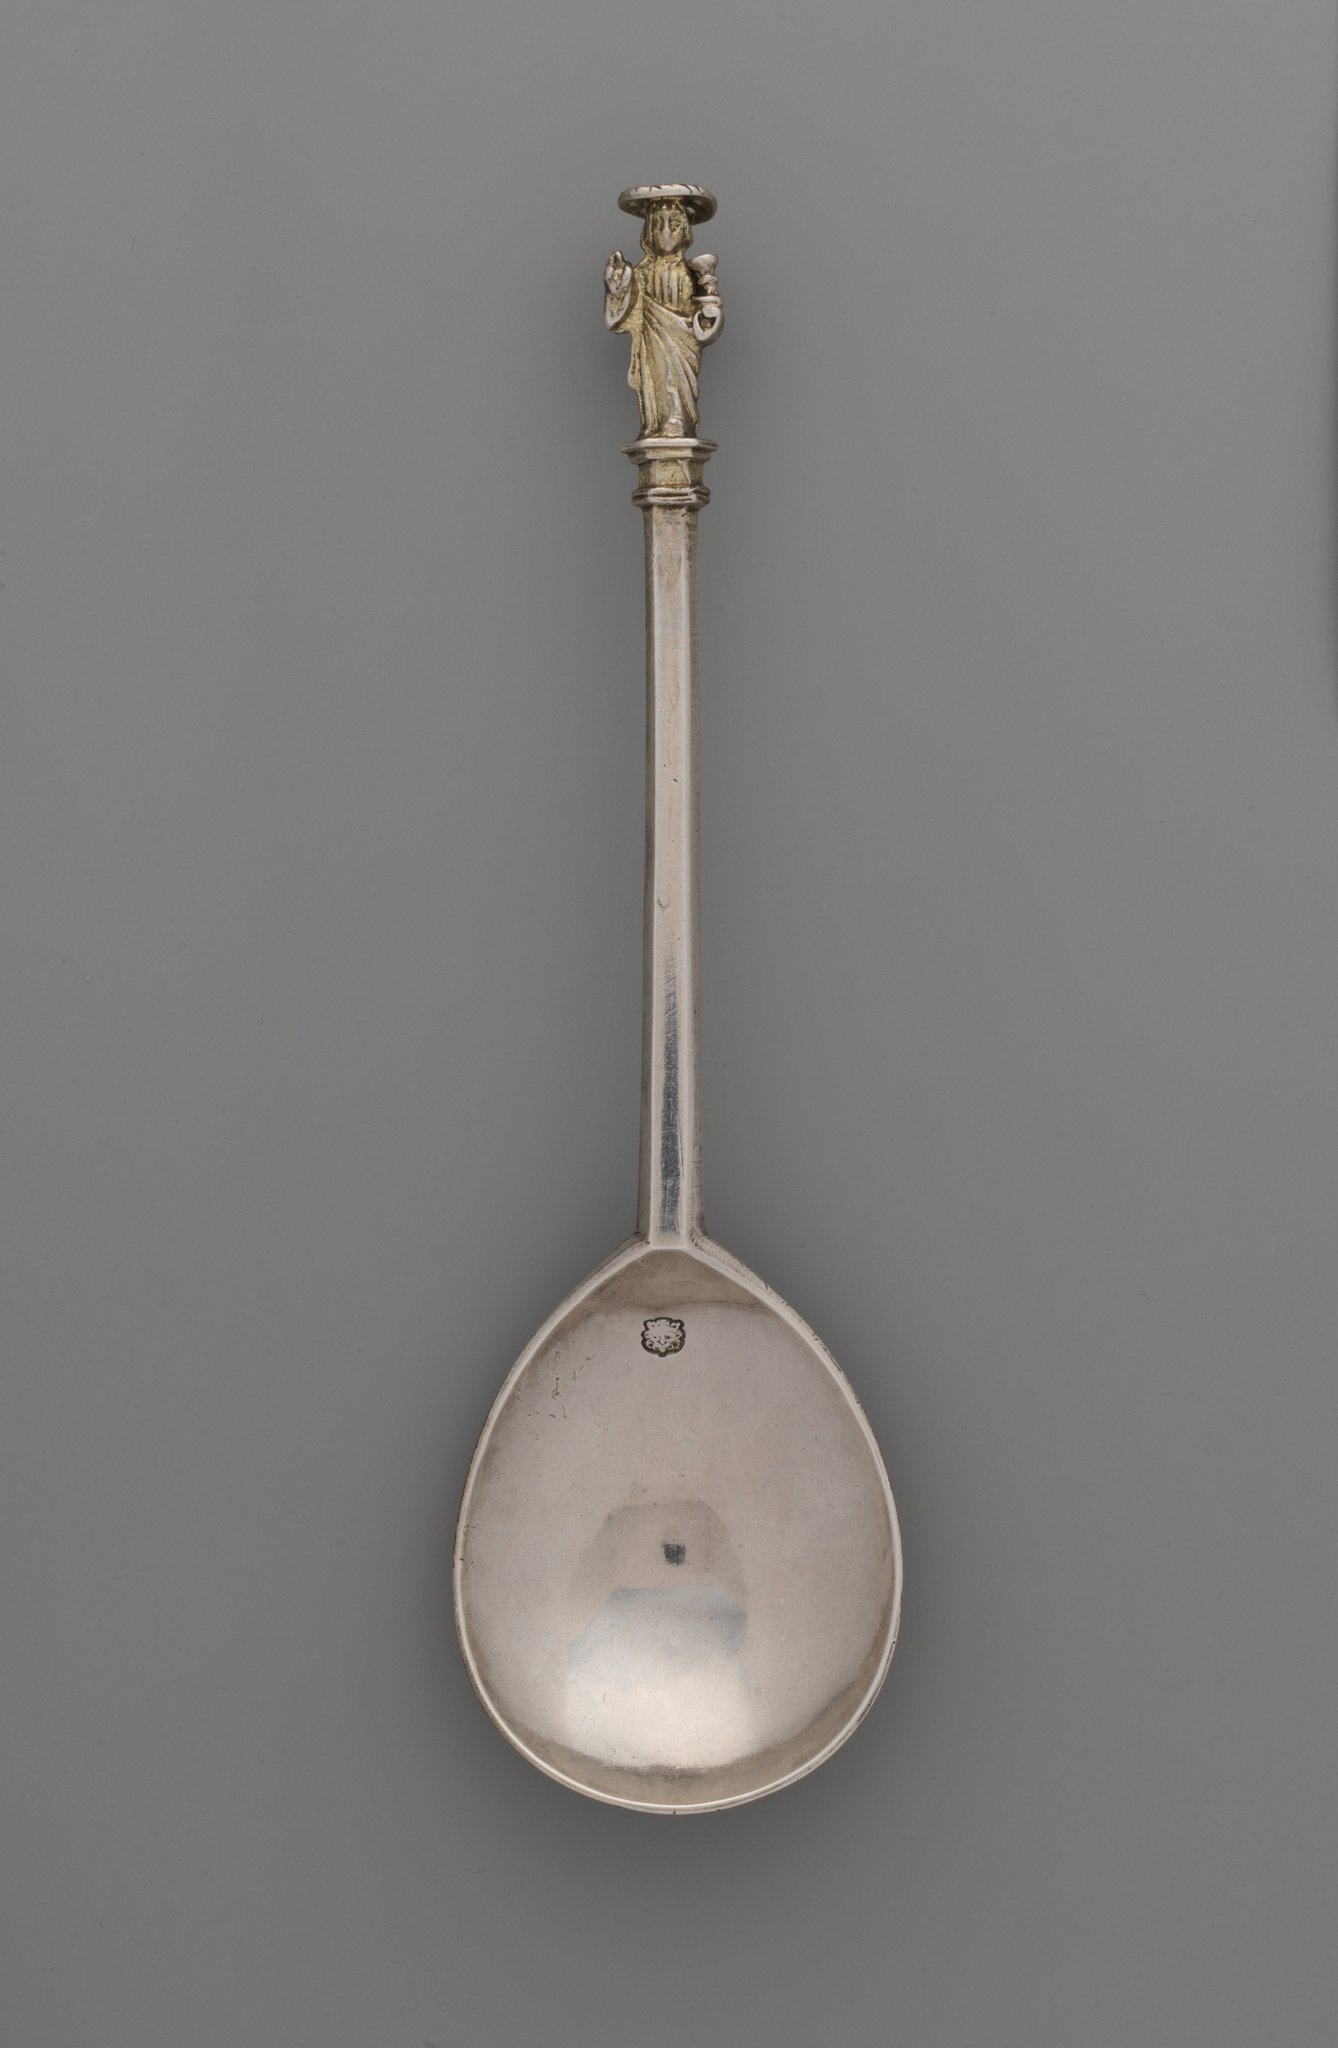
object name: apostle spoon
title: Apostle spoon: St. John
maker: william cawdell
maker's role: maker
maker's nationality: british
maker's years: 1560-1625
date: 1592-1593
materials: silver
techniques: gilding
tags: apostles,saint john the baptist